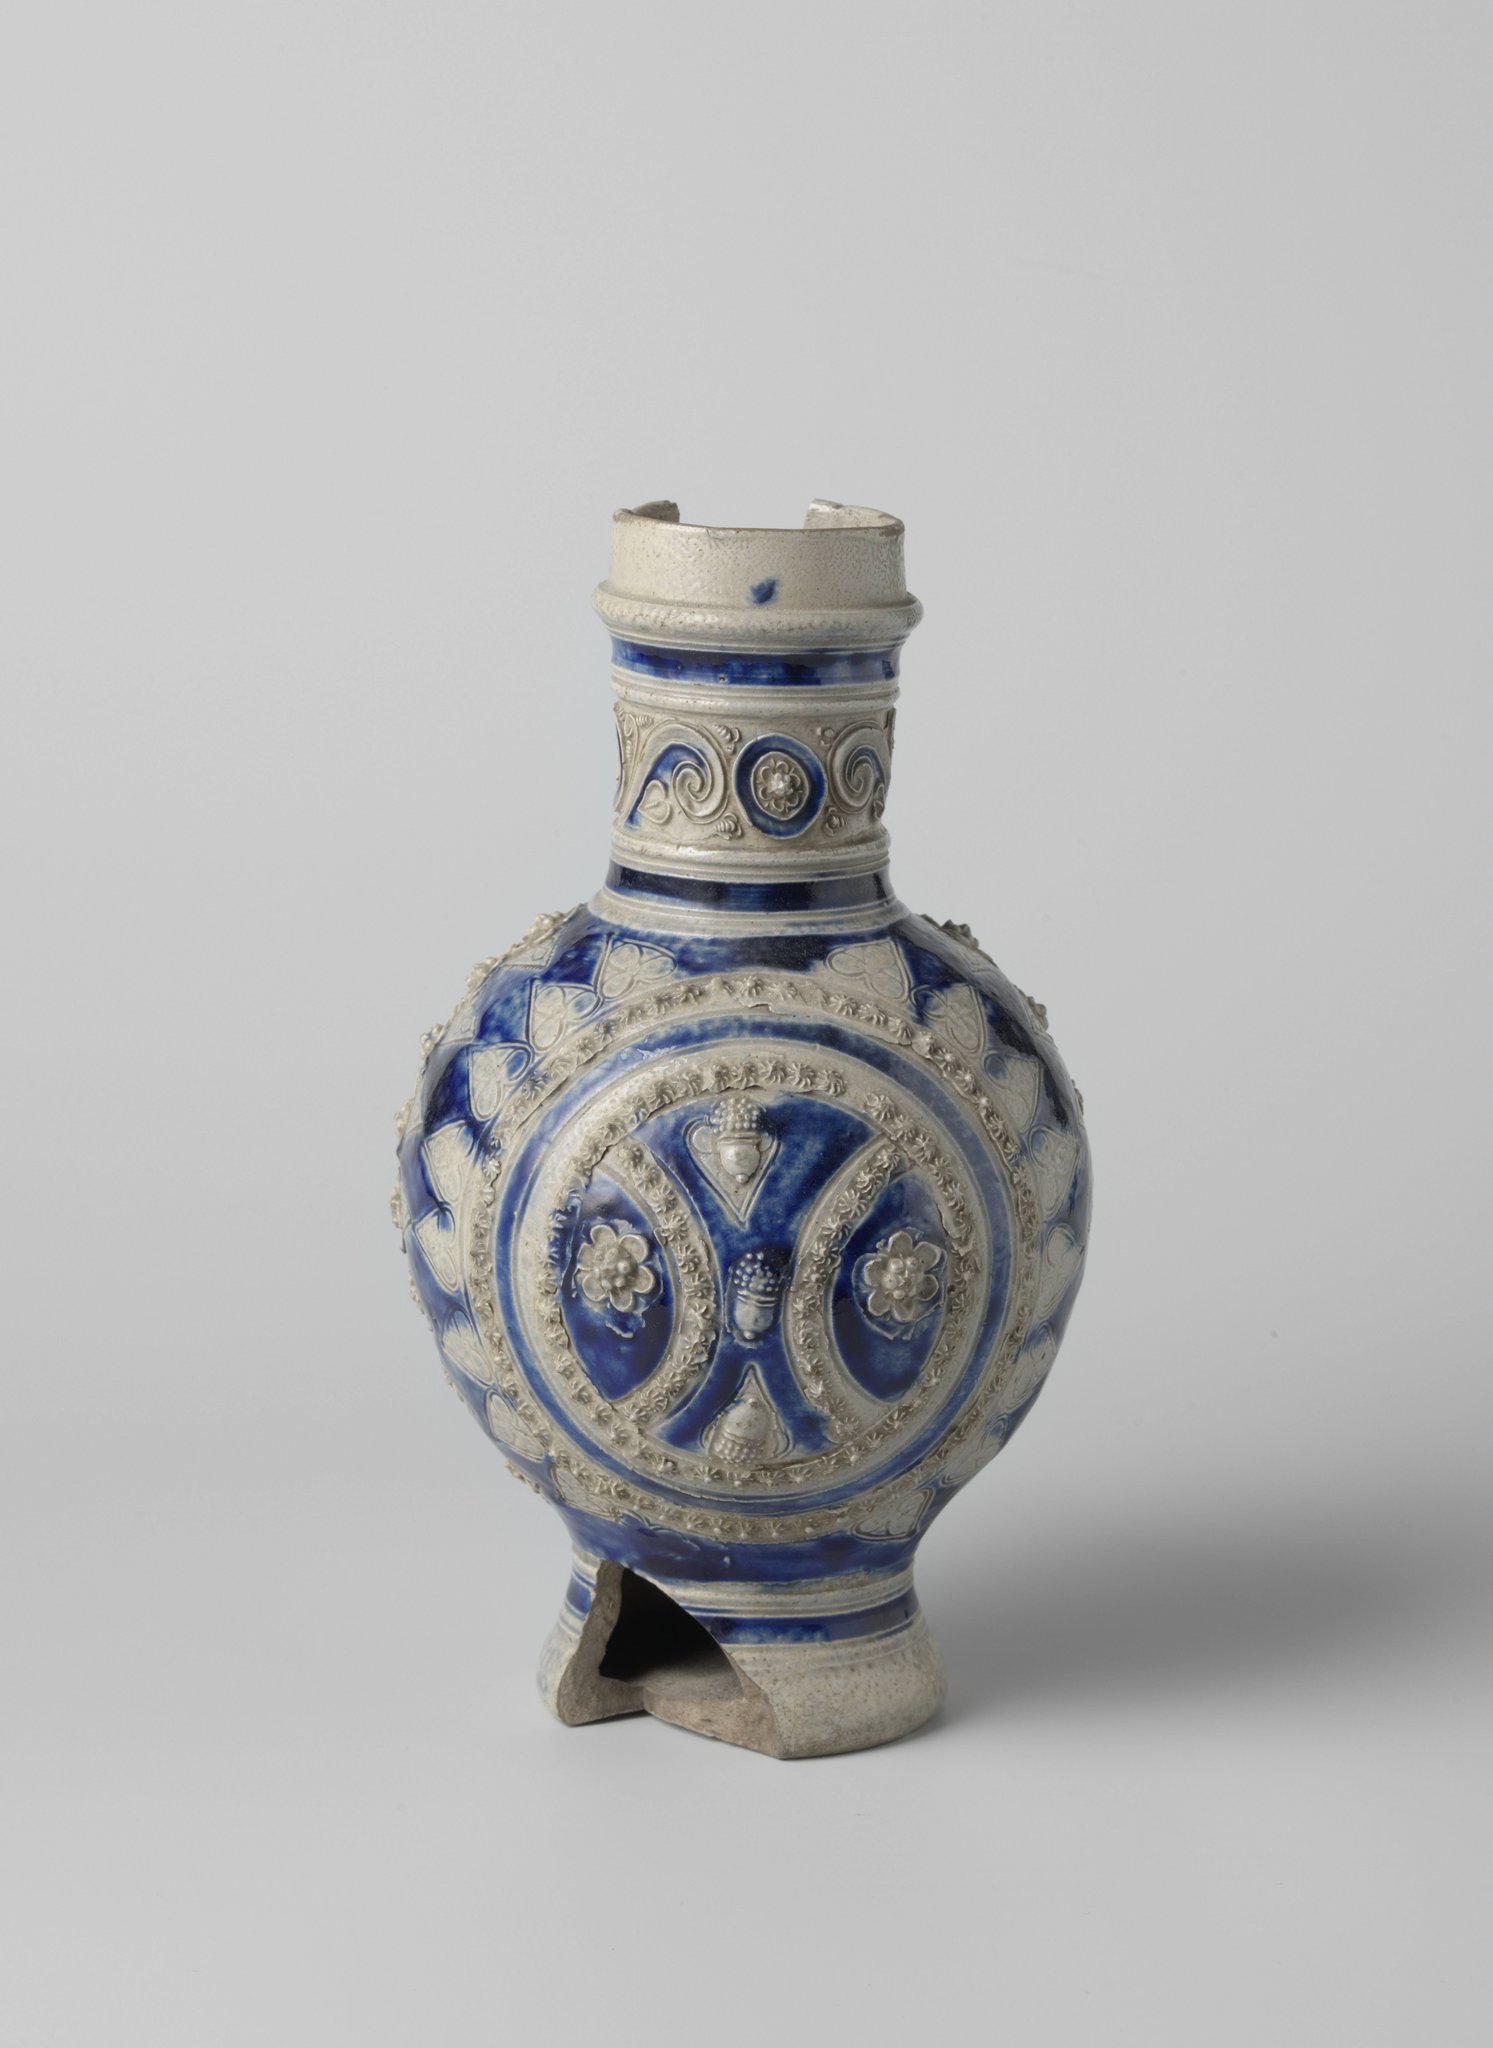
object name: jug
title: Fragment of a jug with roundels, heart shapes and foliate ornaments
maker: Anonymous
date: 1600-1699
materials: cobalt, glaze, stoneware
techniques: printing, firing, forming, relief, turning, vitrification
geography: westerwald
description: Fragment van een kruik van steengoed op hoge voet met een bolvormig lichaam en smalle nek. Het oor en een deel van de nek en voet ontbreken. Profielen op de voet en de nek. Gedeeltelijk bedekt met kobaltblauw. Op de buik in reliëf gedrukte en opgelegde, concentrische cirkels van kleine rozetten en gestempelde hartvormen, waarbinnen een driepas. In het centrum drie eikels en twee bloemen in vakken. De zijkant met een verticale band bloemen met aan weerszijden driehoekige bladmotieven. Op de nek een band met krulwerk onderbroken door rozetten in medaillons. Westerwald.